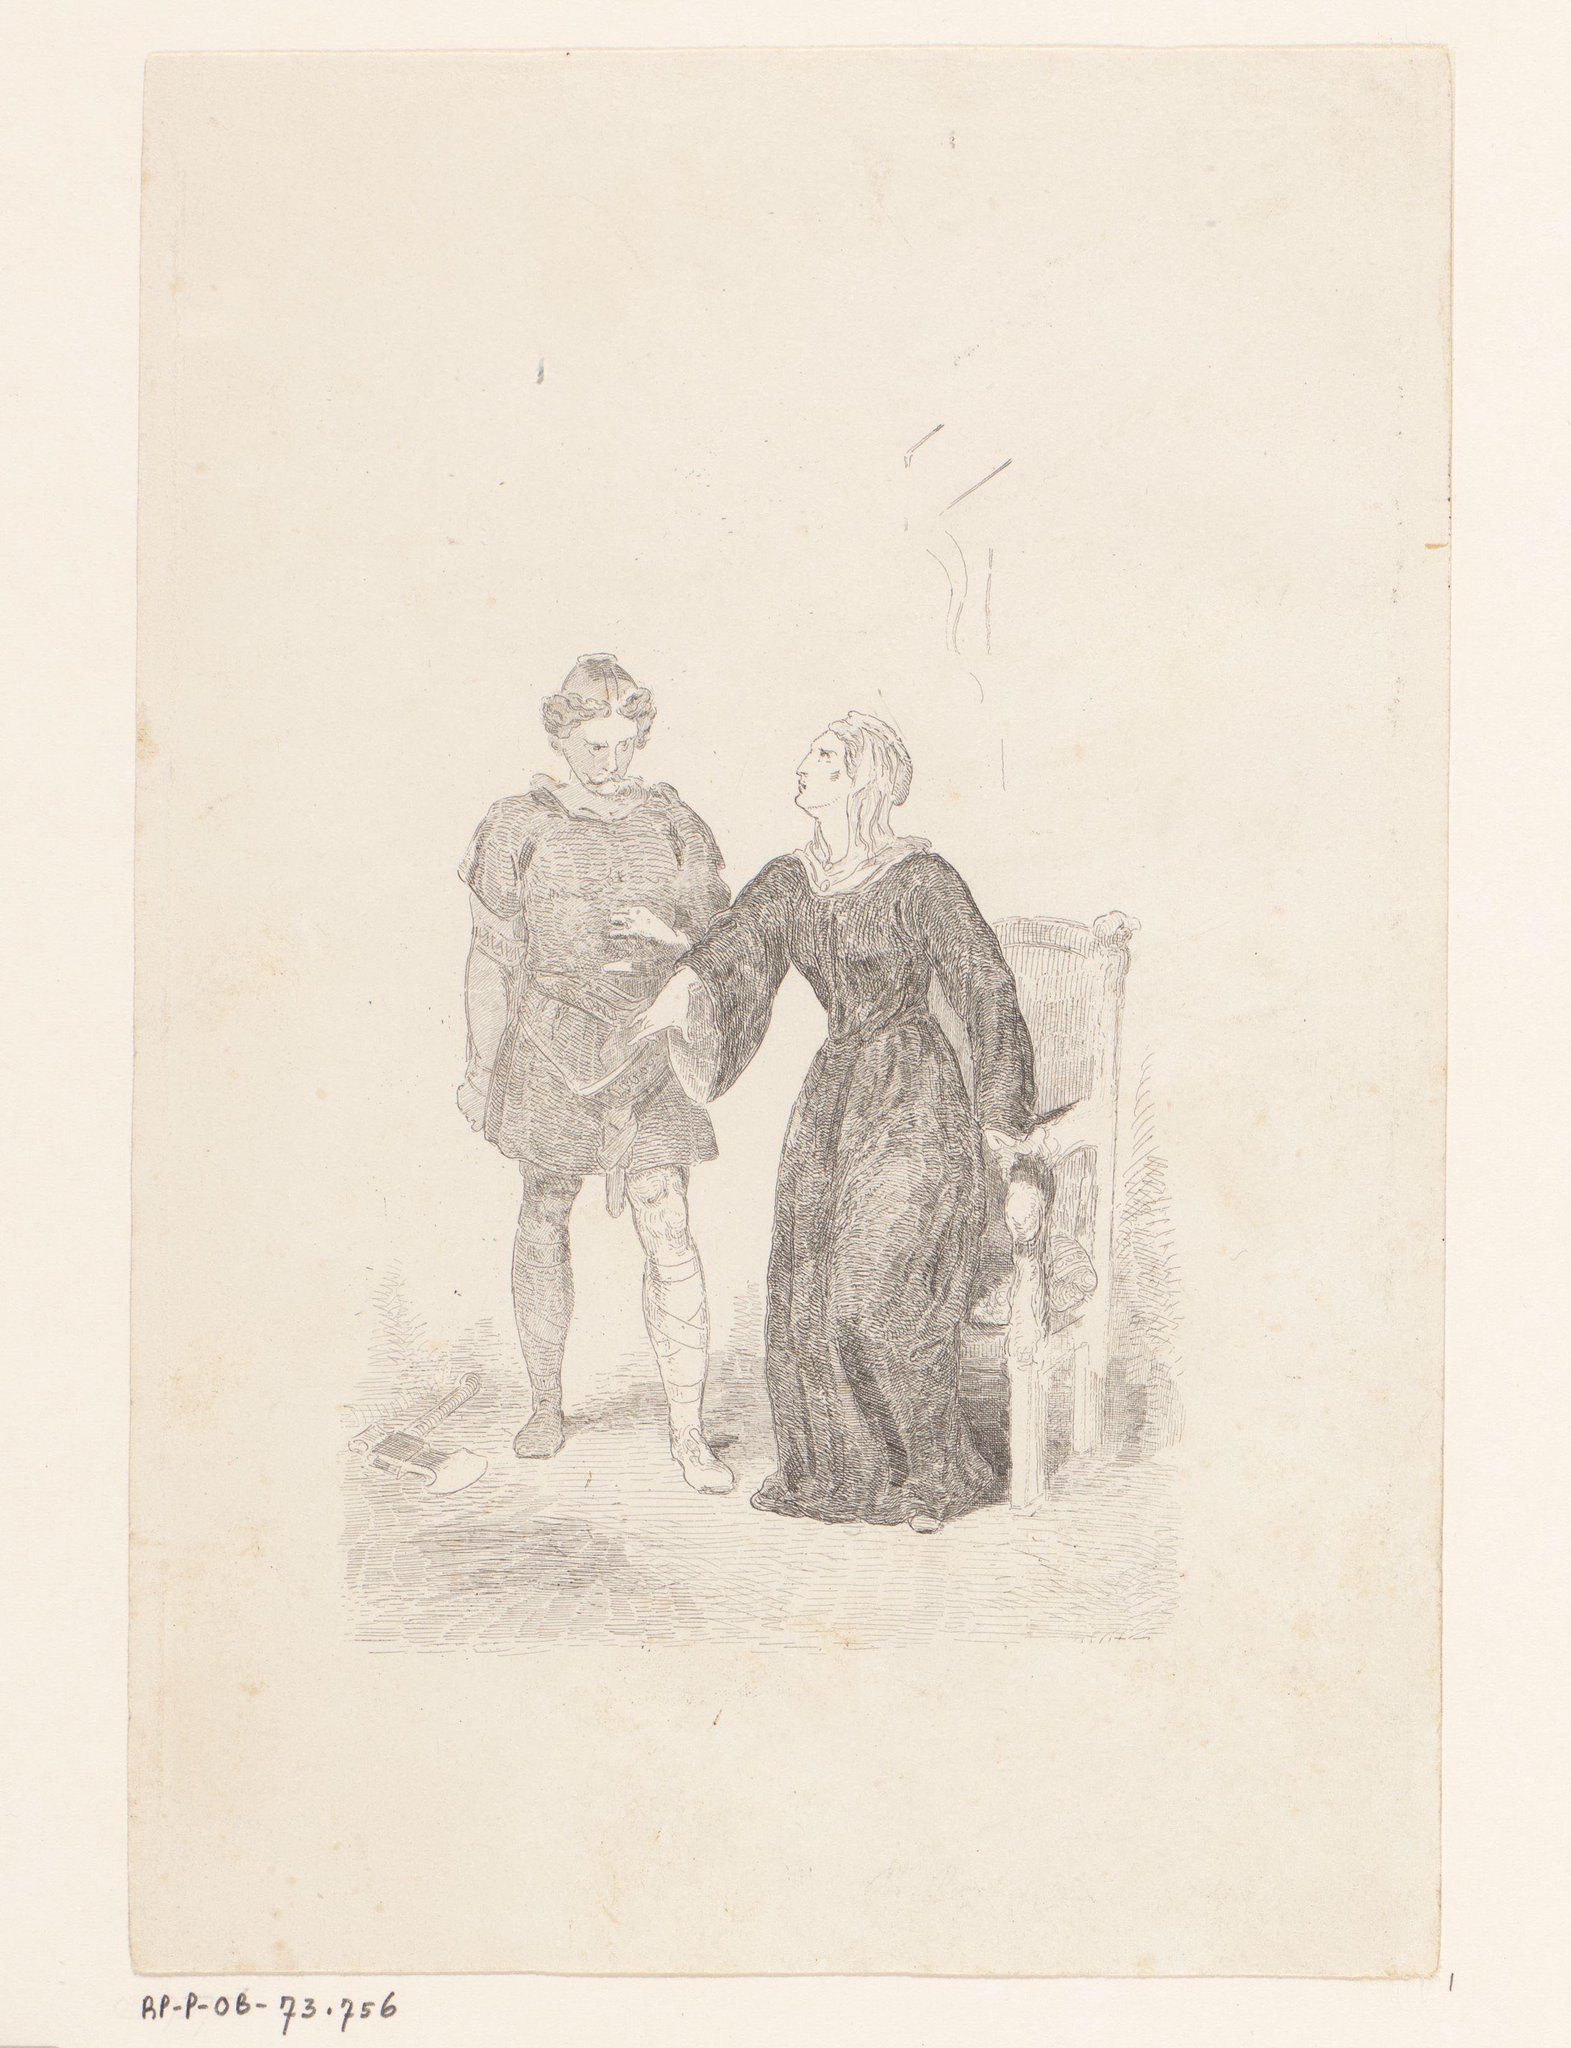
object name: print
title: Wilfried bij zijn moeder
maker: charles rochussen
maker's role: draughtsman, painter, print maker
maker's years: 1814-1894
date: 1854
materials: paper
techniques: steel etching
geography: amsterdam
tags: mother with son(s) and daughter(s) (mother-love)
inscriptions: collector's mark: Lugt 2228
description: Wilfried komt bij zijn moeder. Illustratie van een scène uit een boek met gedichten genaamd 'Helene'.